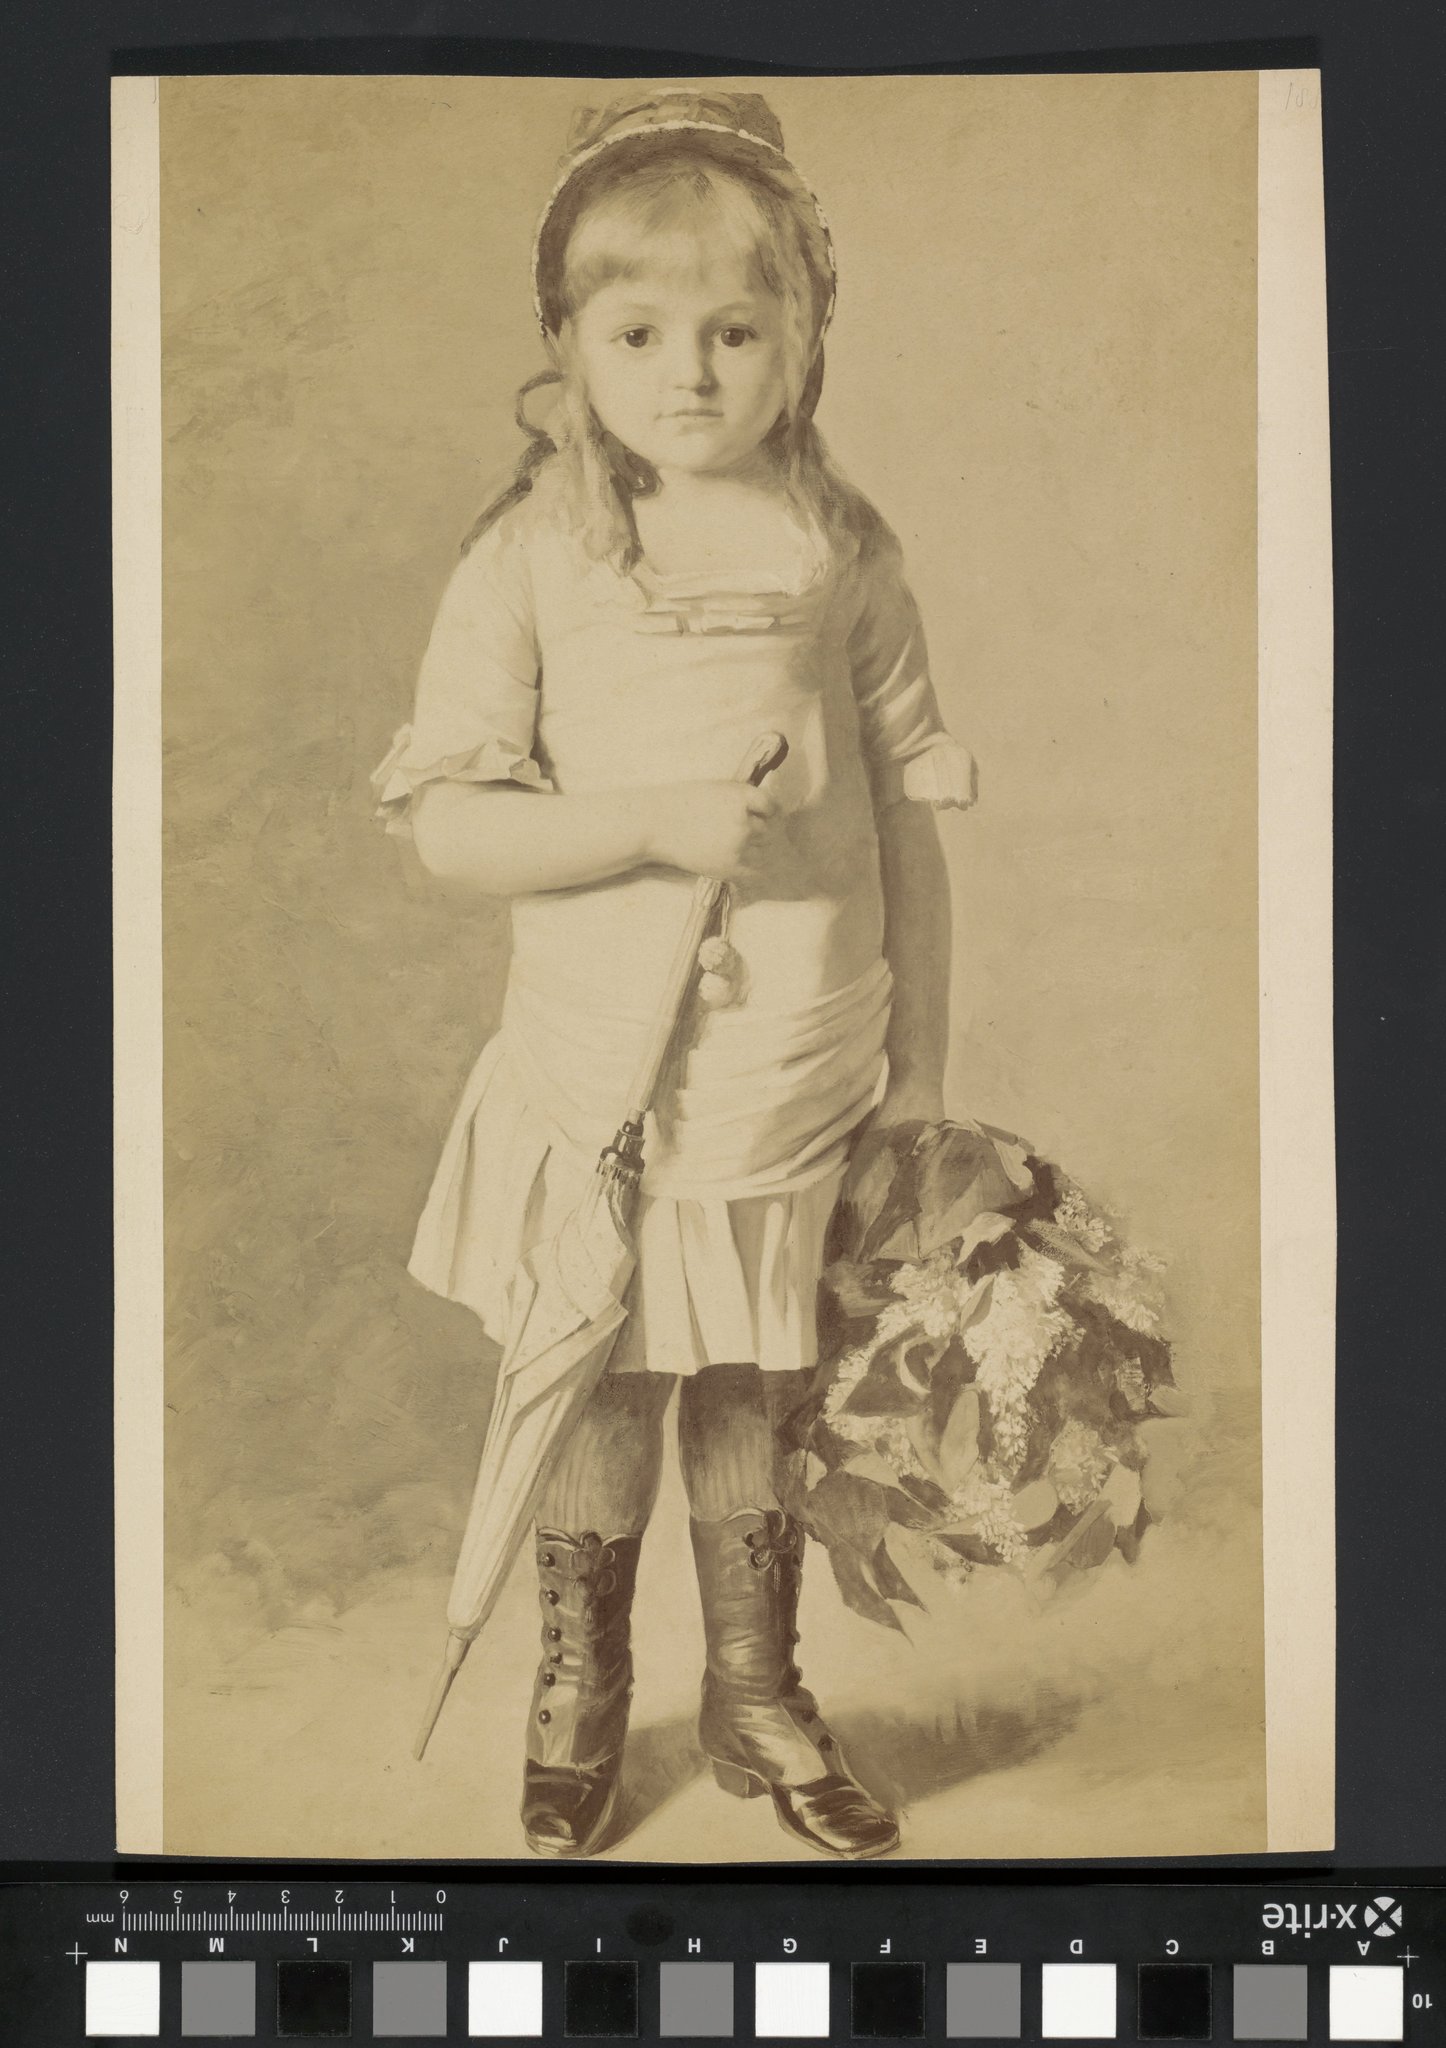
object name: reproduction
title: Fotoreproductie van (vermoedelijk) een geschilderd portret van een jong meisje met bloemen en een paraplu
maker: Anonymous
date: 1882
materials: cardboard, paper, photographic support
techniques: albumen print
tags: cut flowers; nosegay, bunch of flowers, child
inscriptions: date: ‘1882’, name: ‘[...]ina Kohnstamm ?’